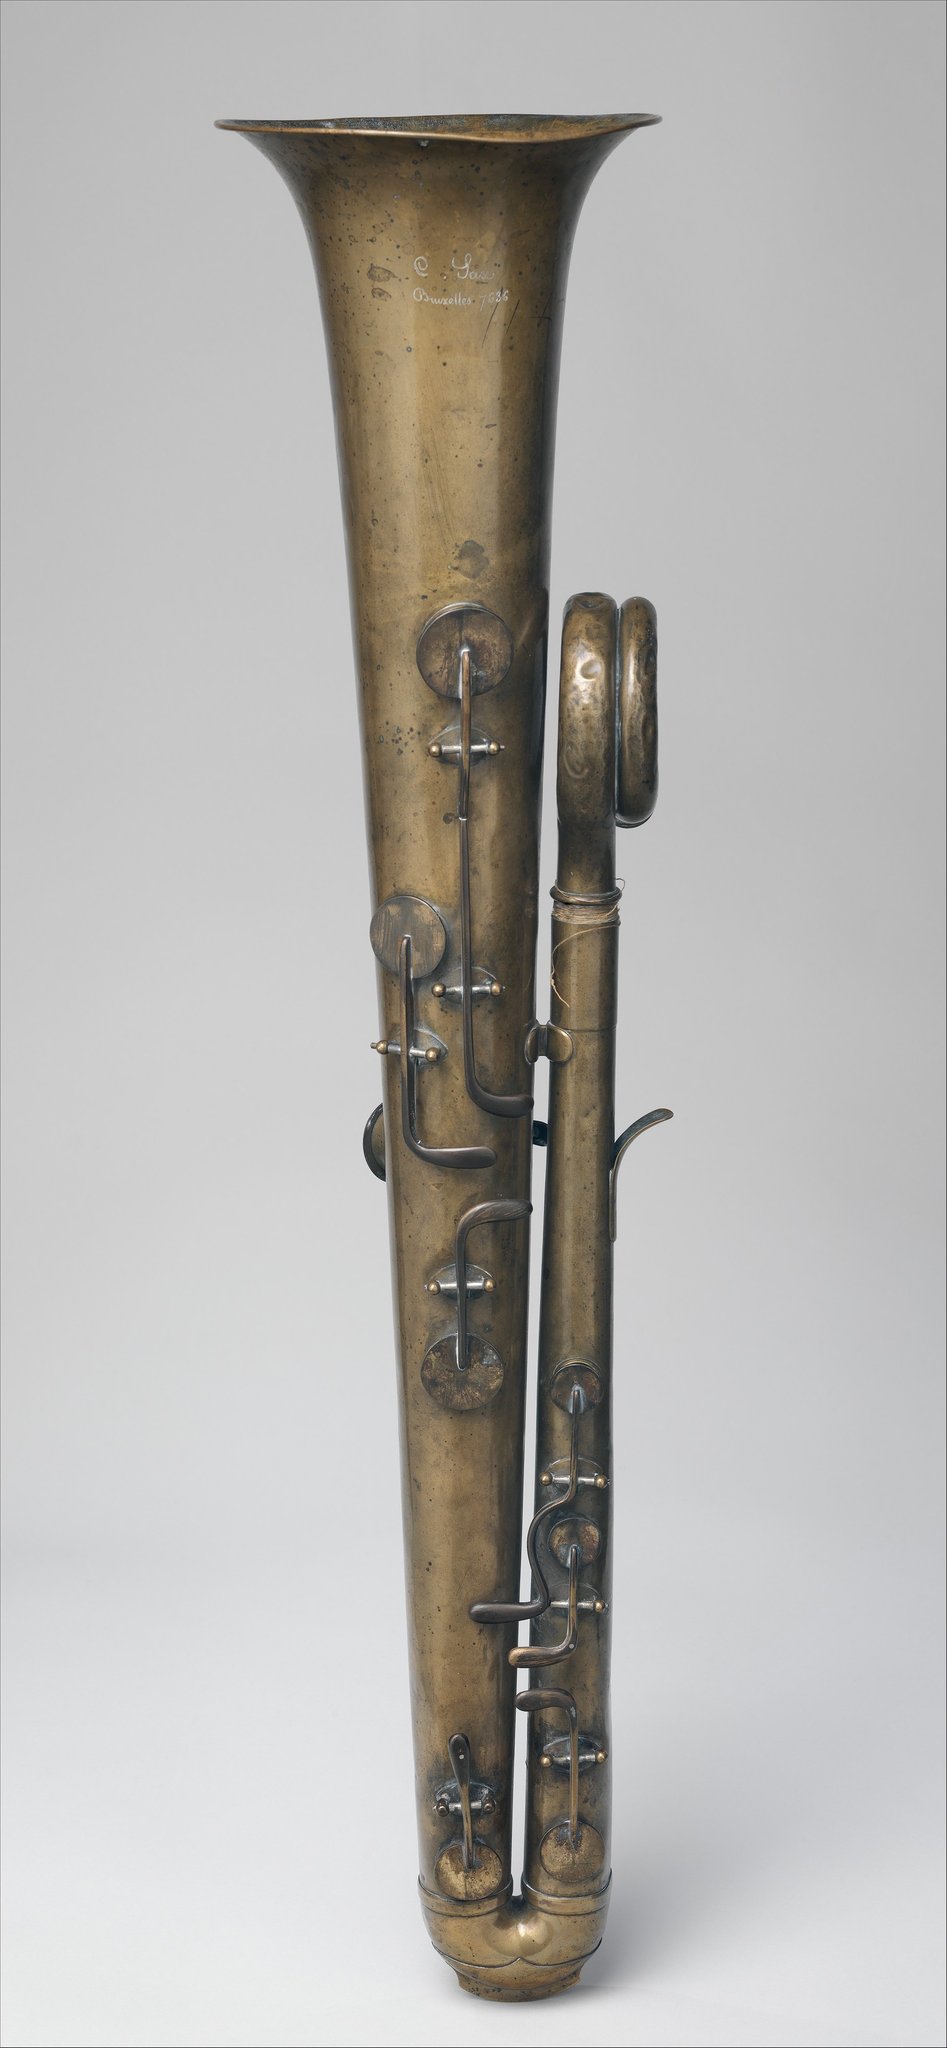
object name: tenor alto ophicleide in e flat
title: Tenor (Alto) Ophicleide in E-flat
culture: belgian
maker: charles joseph sax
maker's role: maker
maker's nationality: belgian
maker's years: 1790-1865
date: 1845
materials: brass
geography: belgium